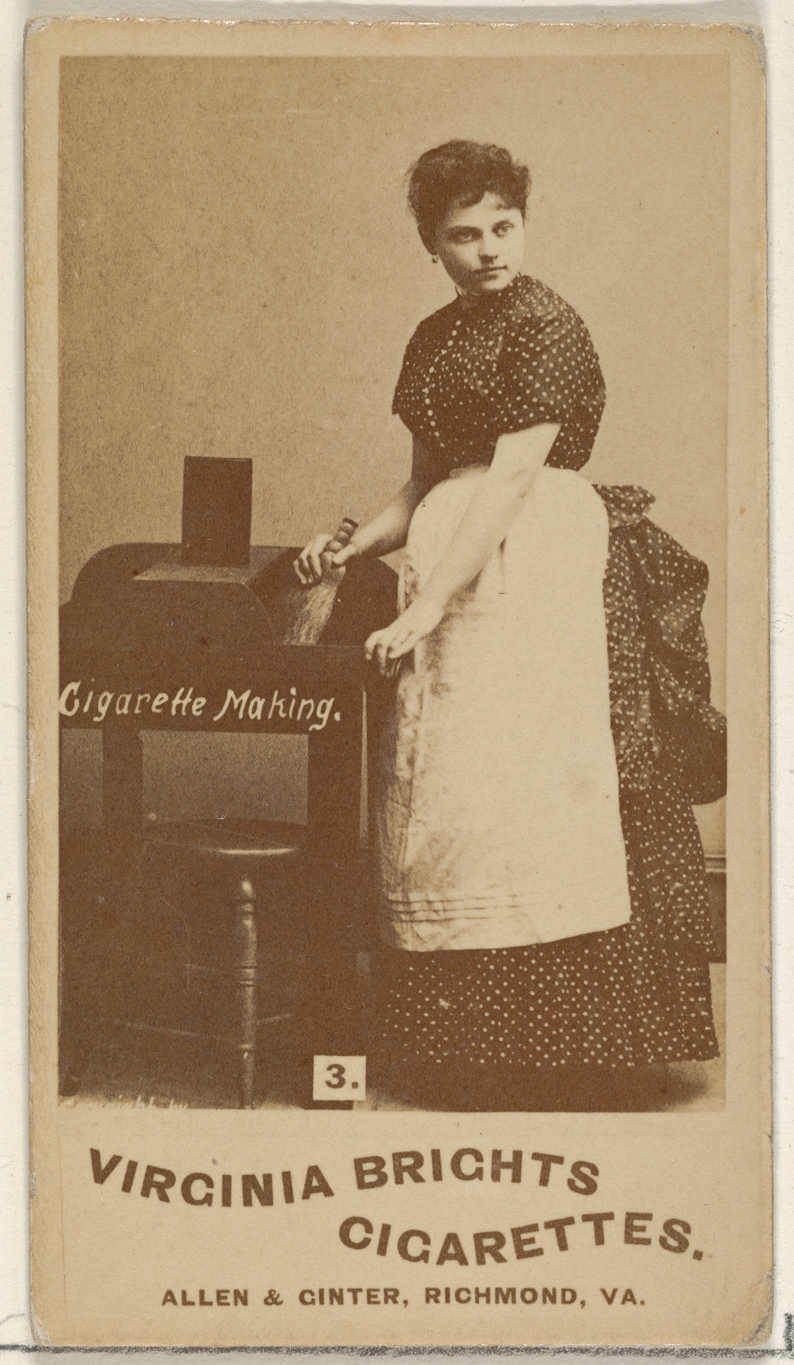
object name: photograph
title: Card 3, from the series, Cigarette Making Girls (N46) for Virginia Brights Cigarettes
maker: allen & ginter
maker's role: publisher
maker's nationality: american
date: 1888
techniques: albumen silver print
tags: portraits,women